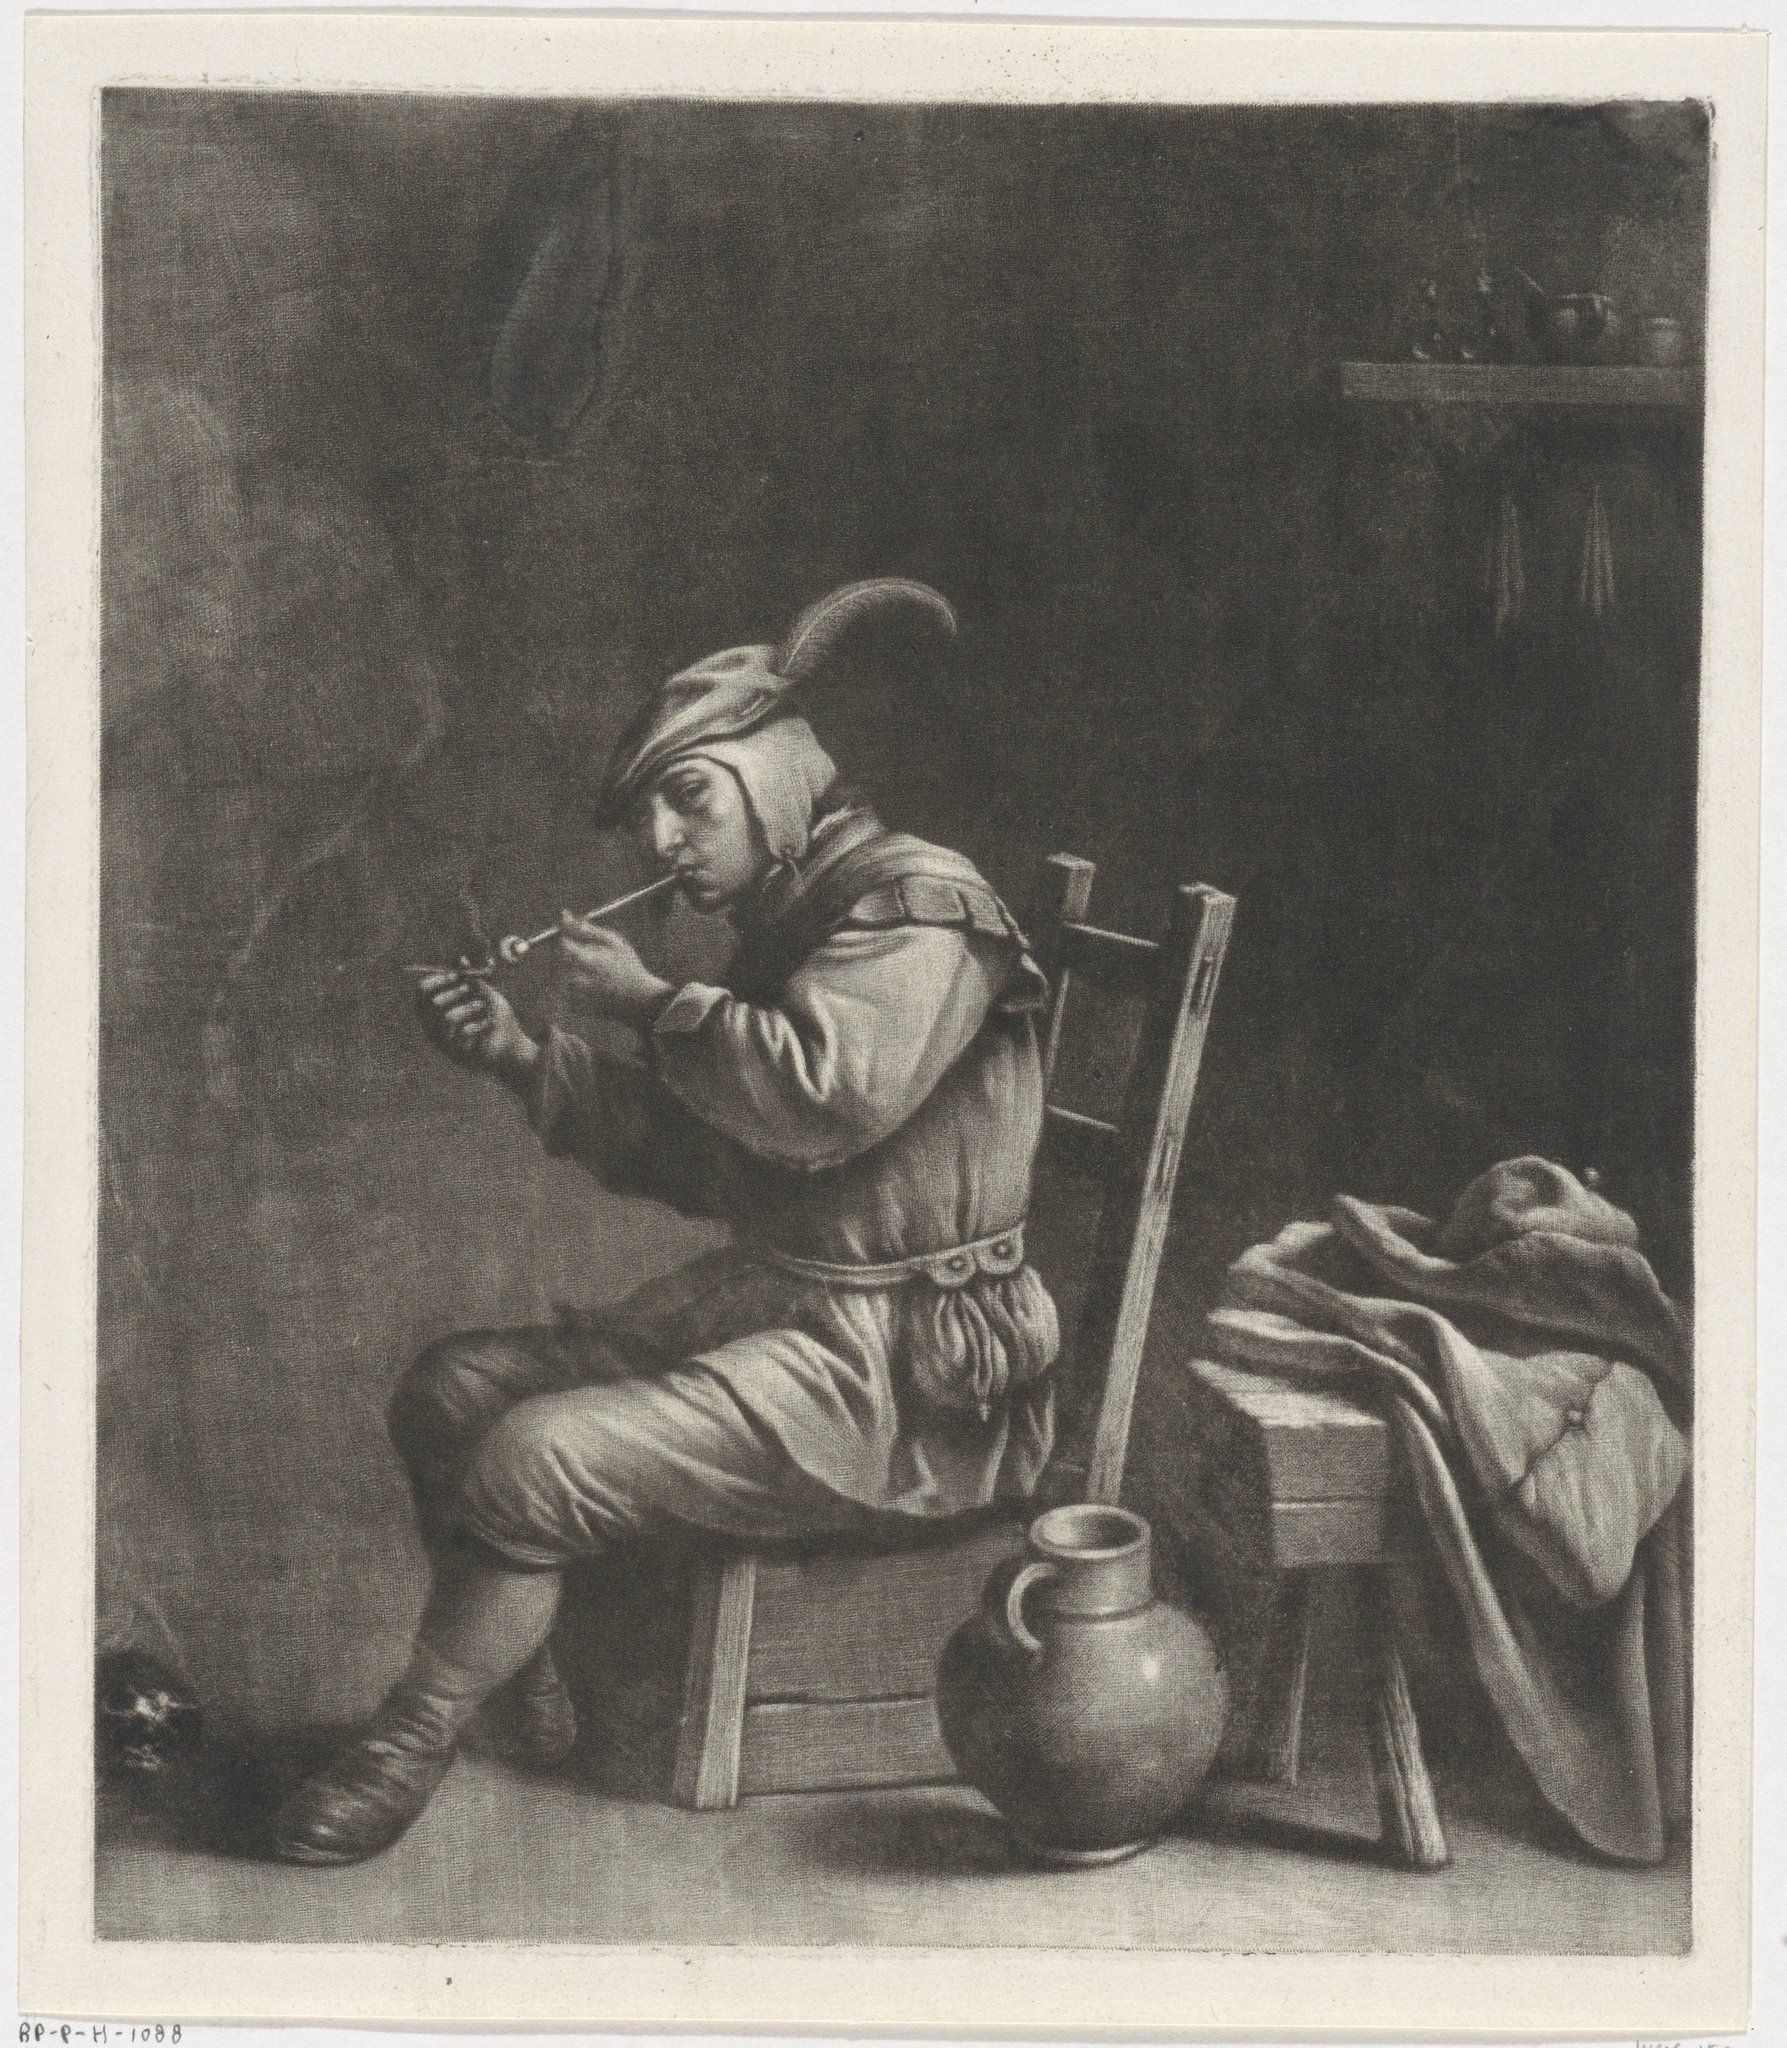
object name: print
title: Man steekt zijn pijp op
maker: wallerant vaillant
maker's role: draughtsman, painter, print maker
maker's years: 1623-1677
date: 1658-1677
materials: paper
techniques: mezzotint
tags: pipe ~ tobacco, head-gear: hat (+ men's clothes)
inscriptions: collector's mark: Lugt 10, collector's mark: Lugt 11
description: Een jonge man met een gevederde muts steekt zijn pijp op.